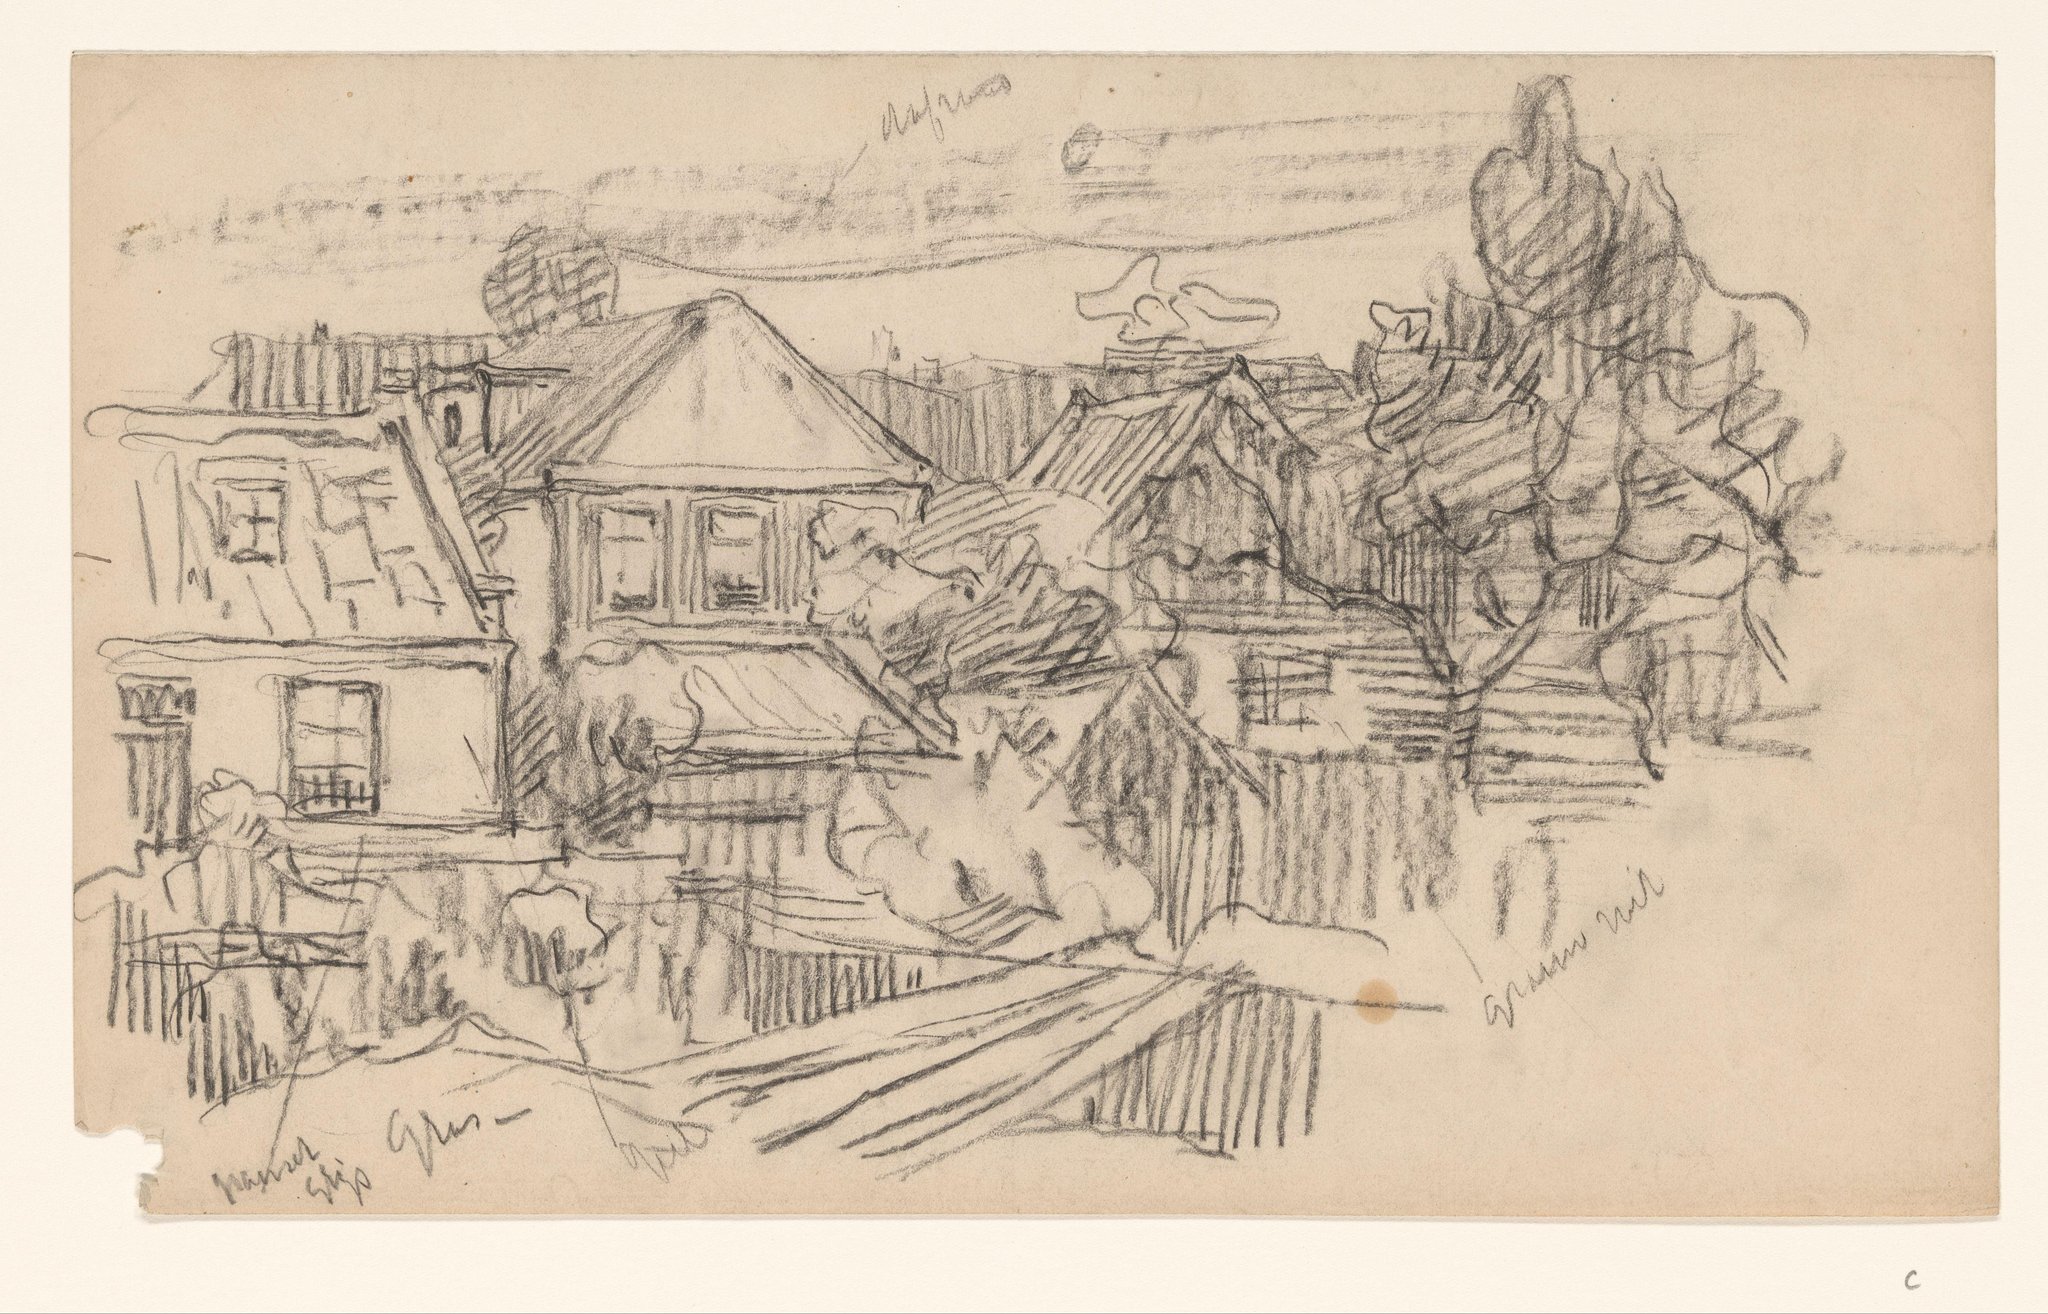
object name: drawing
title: Huizen, met kleurnotities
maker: wilhelmus johannes steenhoff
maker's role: draughtsman, print maker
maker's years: 1863-1932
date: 1873-1932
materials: chalk, paper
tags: city-view, and landscape with man-made constructions